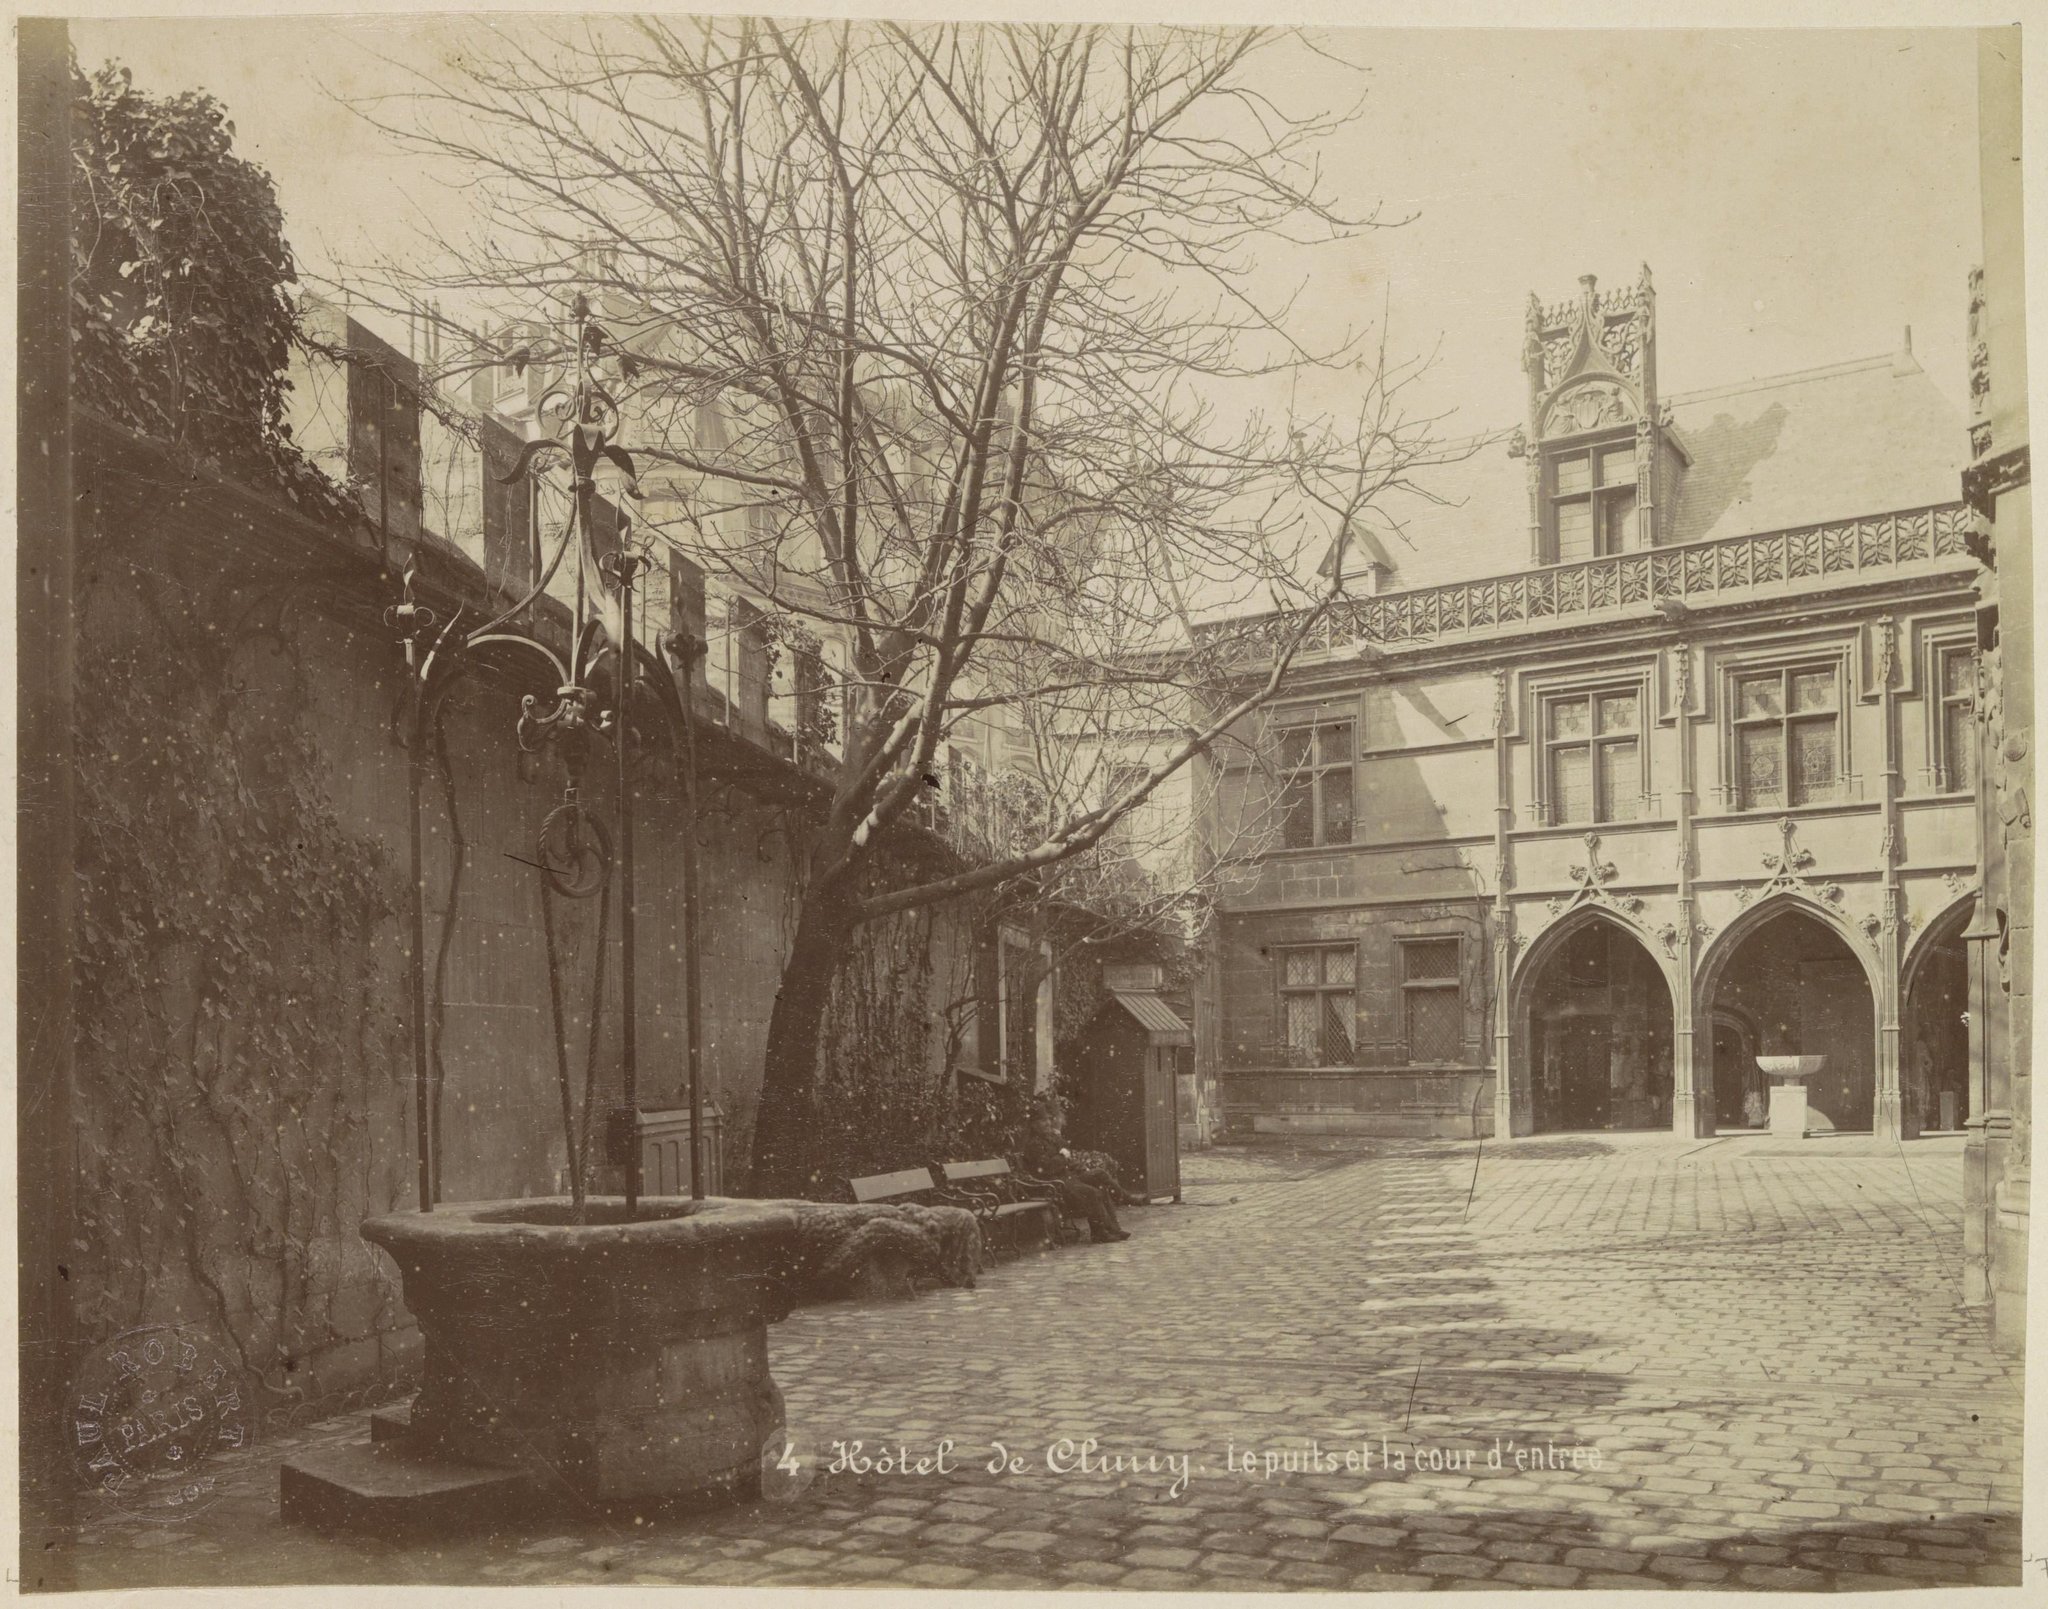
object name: photograph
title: Binnenplaats met waterput van het Hôtel de Cluny in Parijs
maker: paul robert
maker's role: fotograaf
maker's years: 1865-1905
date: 1880-1890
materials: paper, photographic support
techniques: albumen print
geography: paris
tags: well, courtyard, façade (of house or building), paris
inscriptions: check stamp: ‘Paul Robert Paris’, negative number: ‘4’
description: Onderdeel van Reisalbum met foto's van bezienswaardigheden in Frankrijk, Griekenland en Turkije.